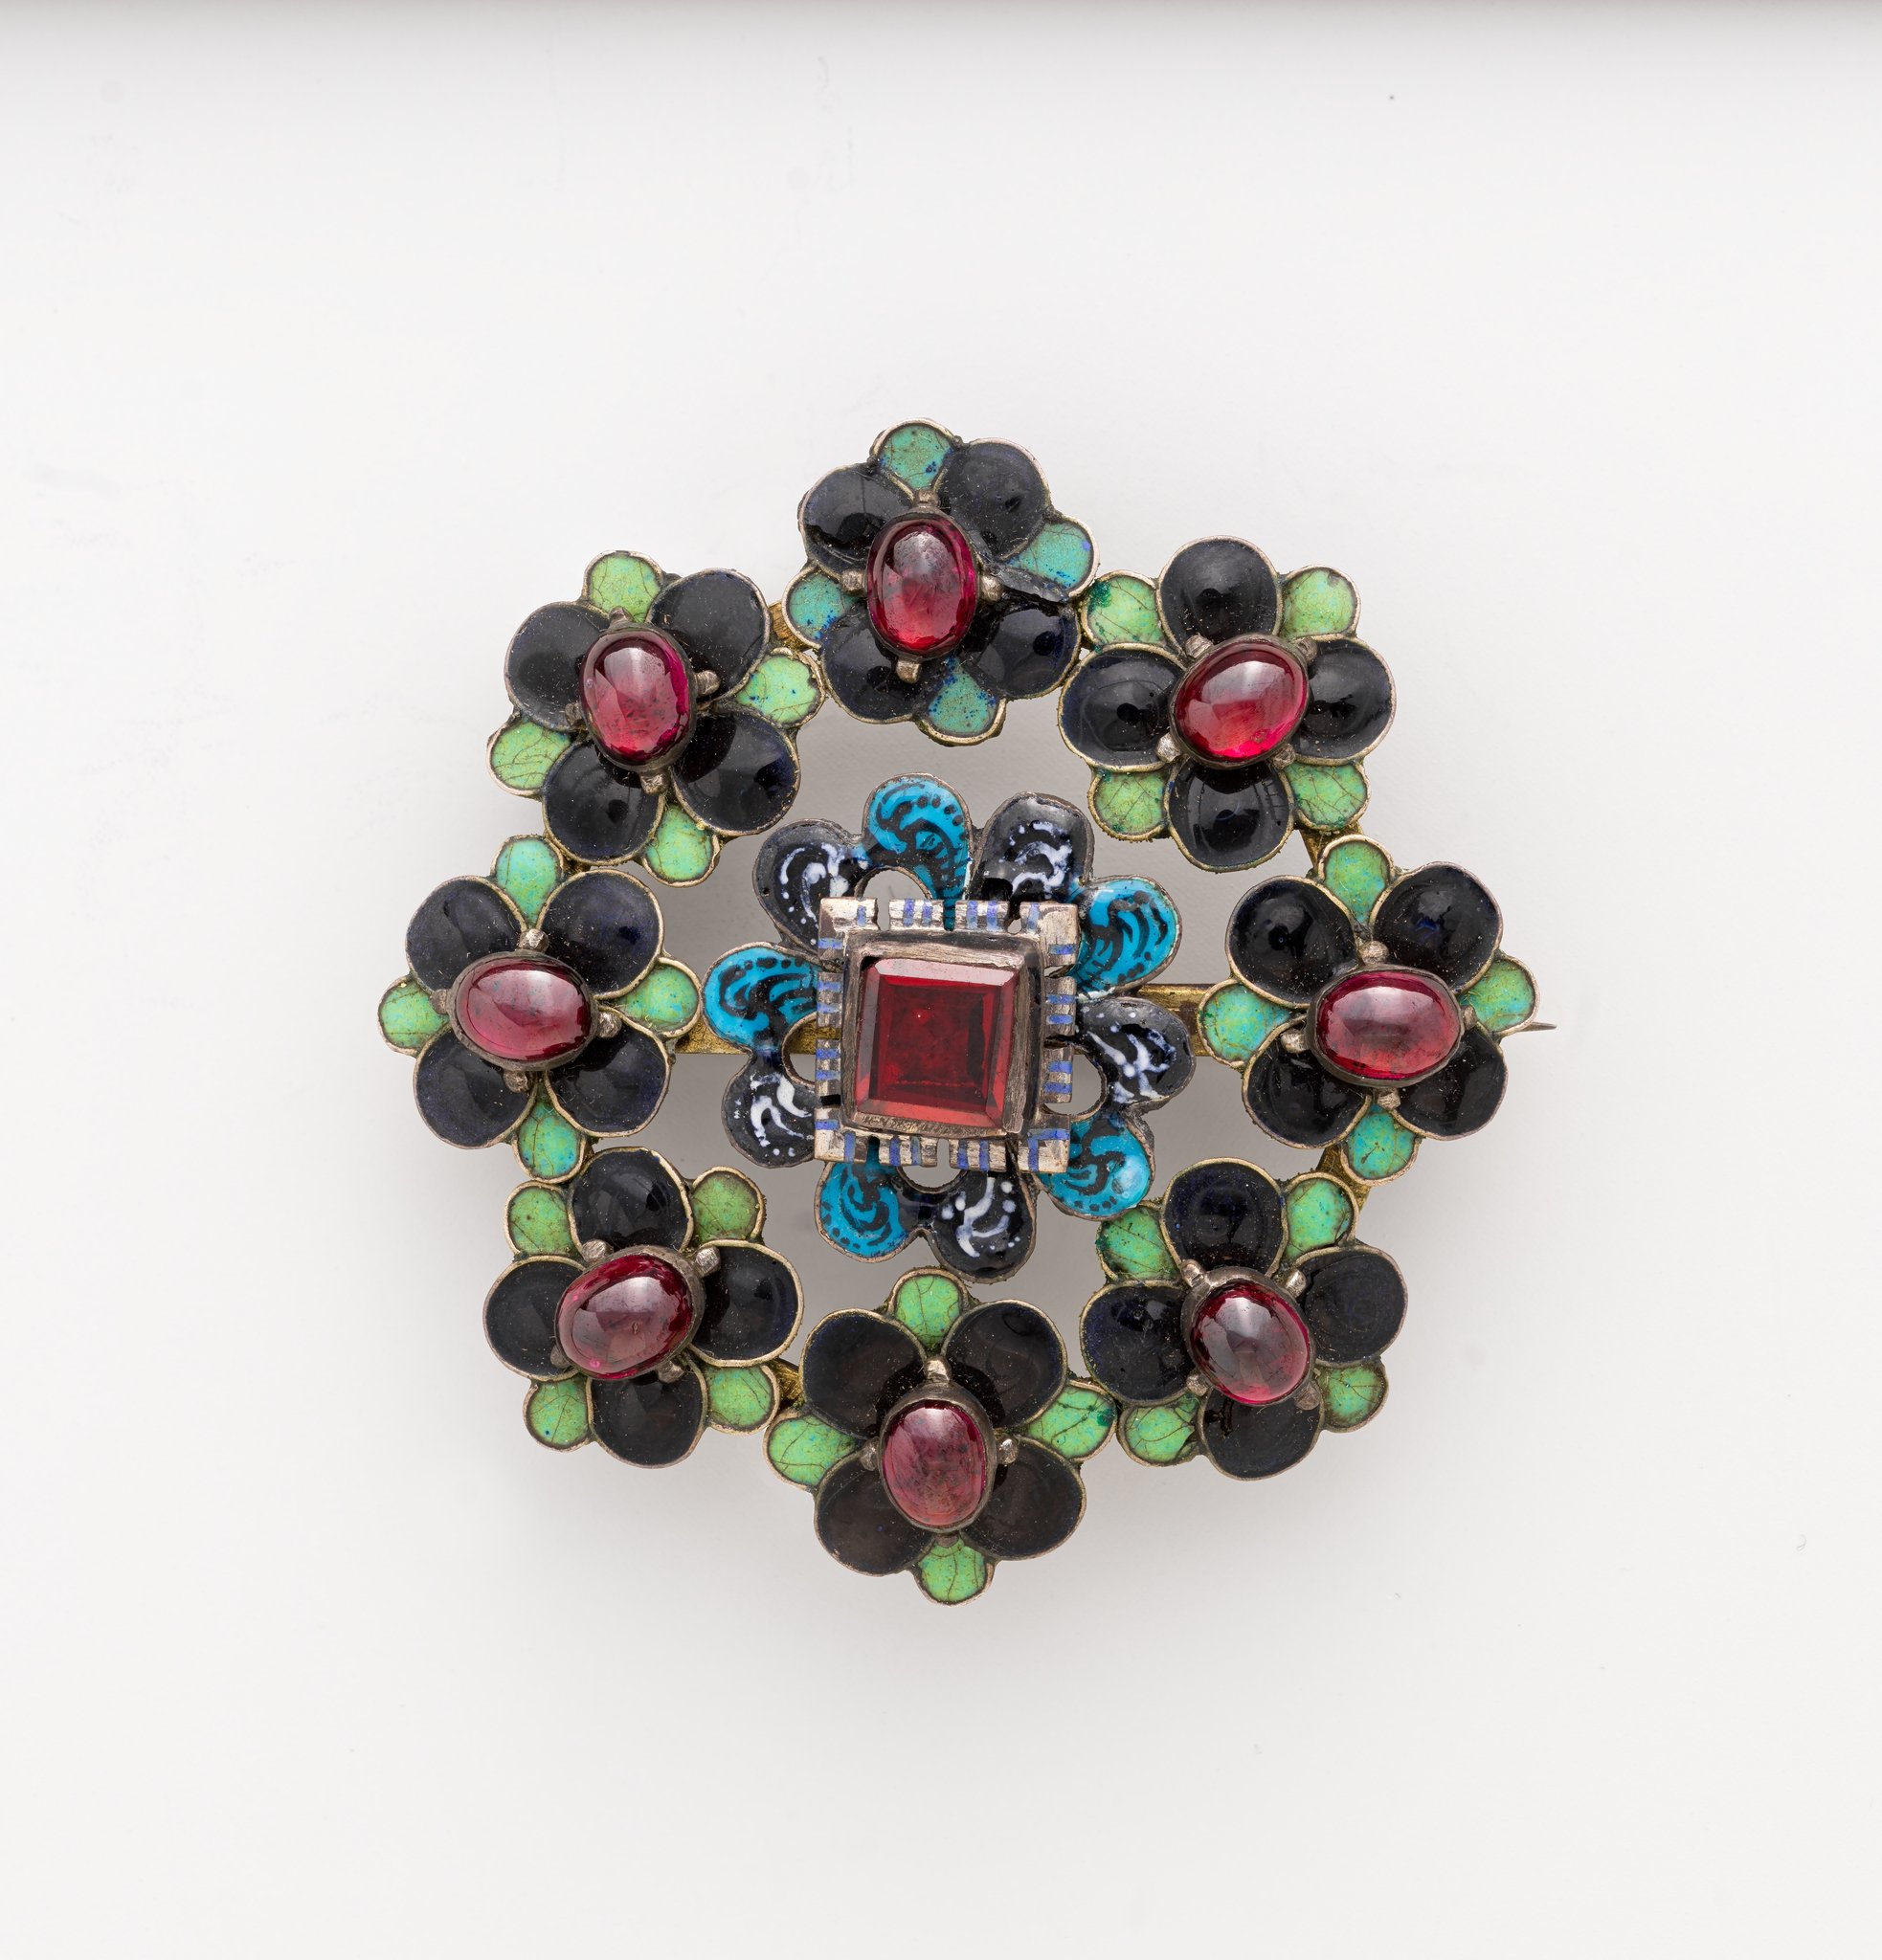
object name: brooch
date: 1801-1900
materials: enamel, garnet, gold, silver